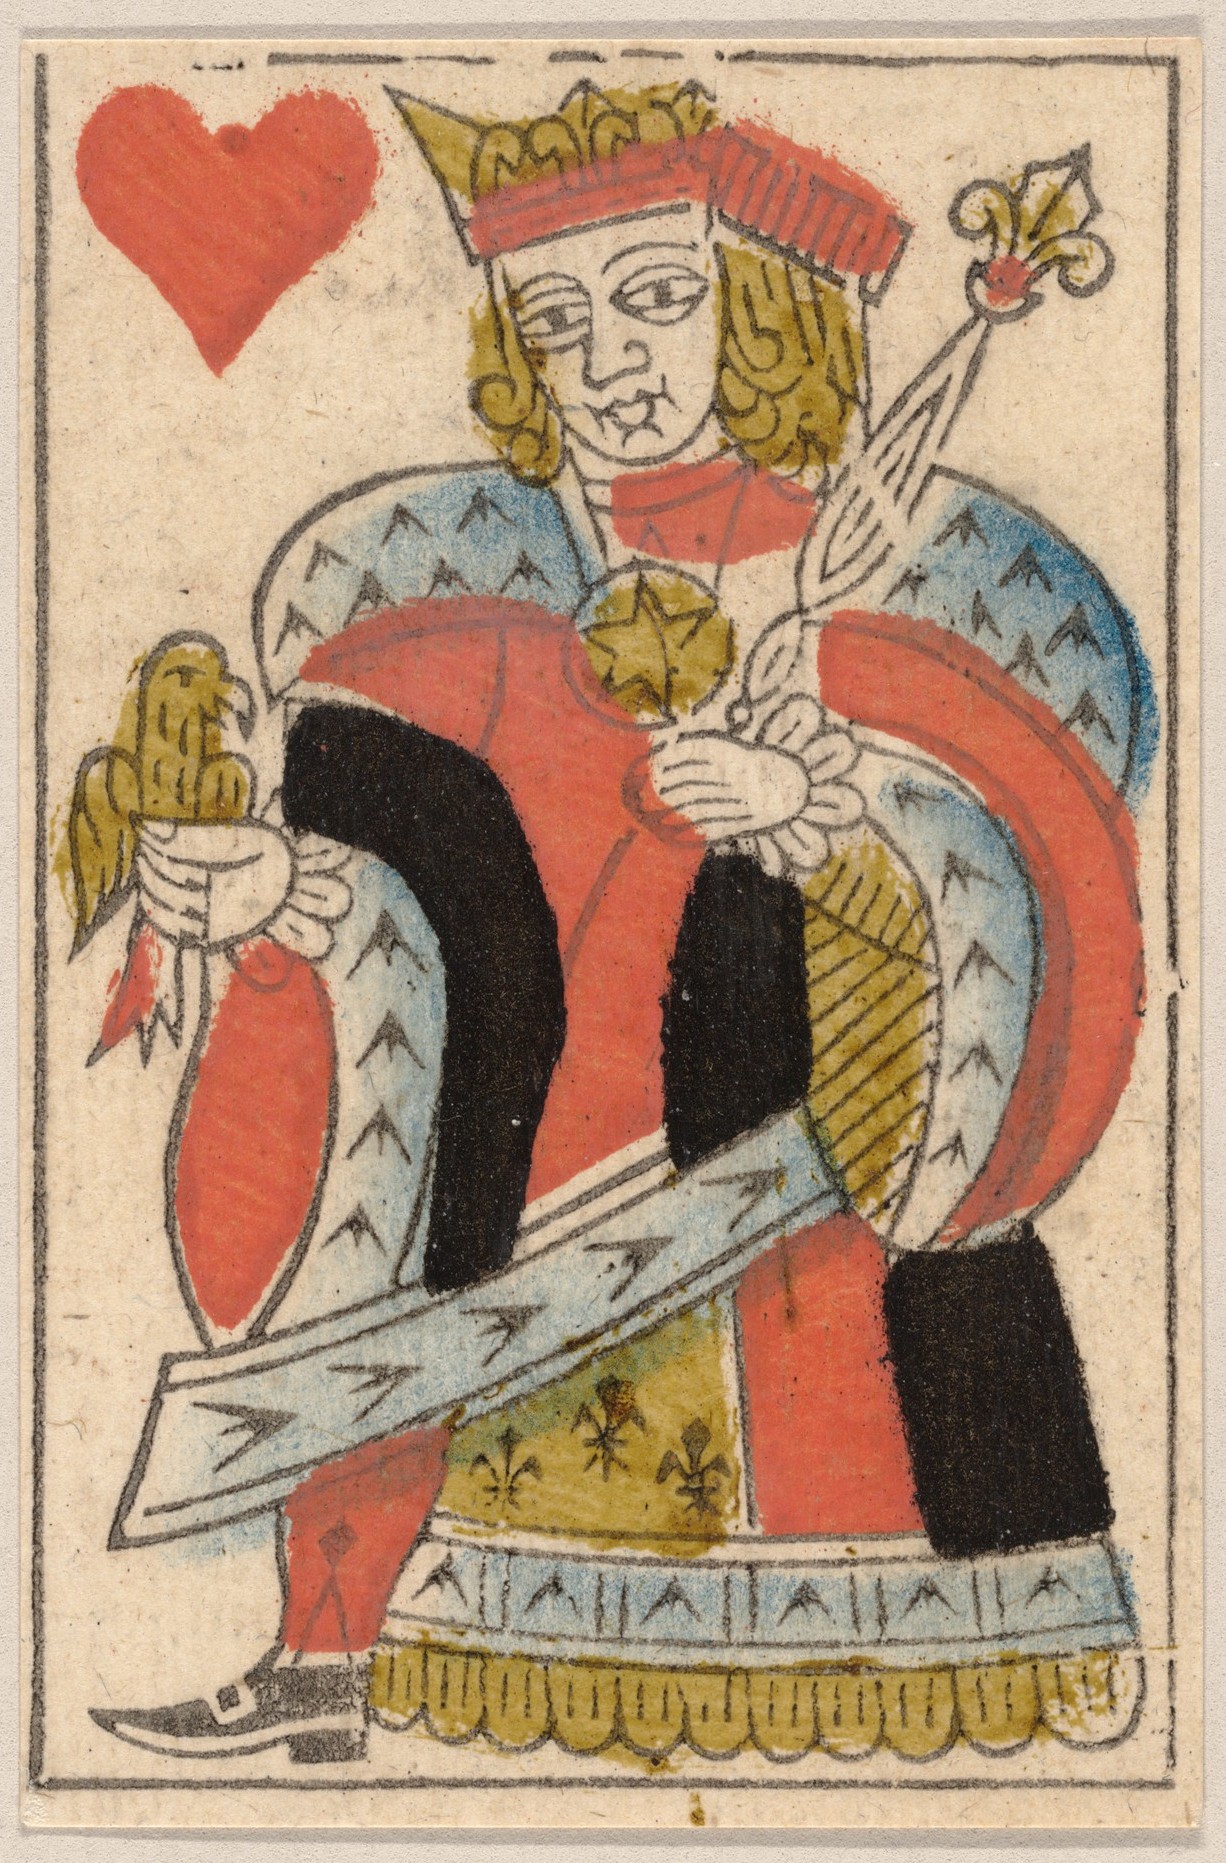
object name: print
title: King of Hearts, from a Set of Piquet Cards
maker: claude fayolle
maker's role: artist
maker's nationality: french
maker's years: 1752-1826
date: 1767-1900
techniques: hand coloring, woodcut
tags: birds,kings,playing cards